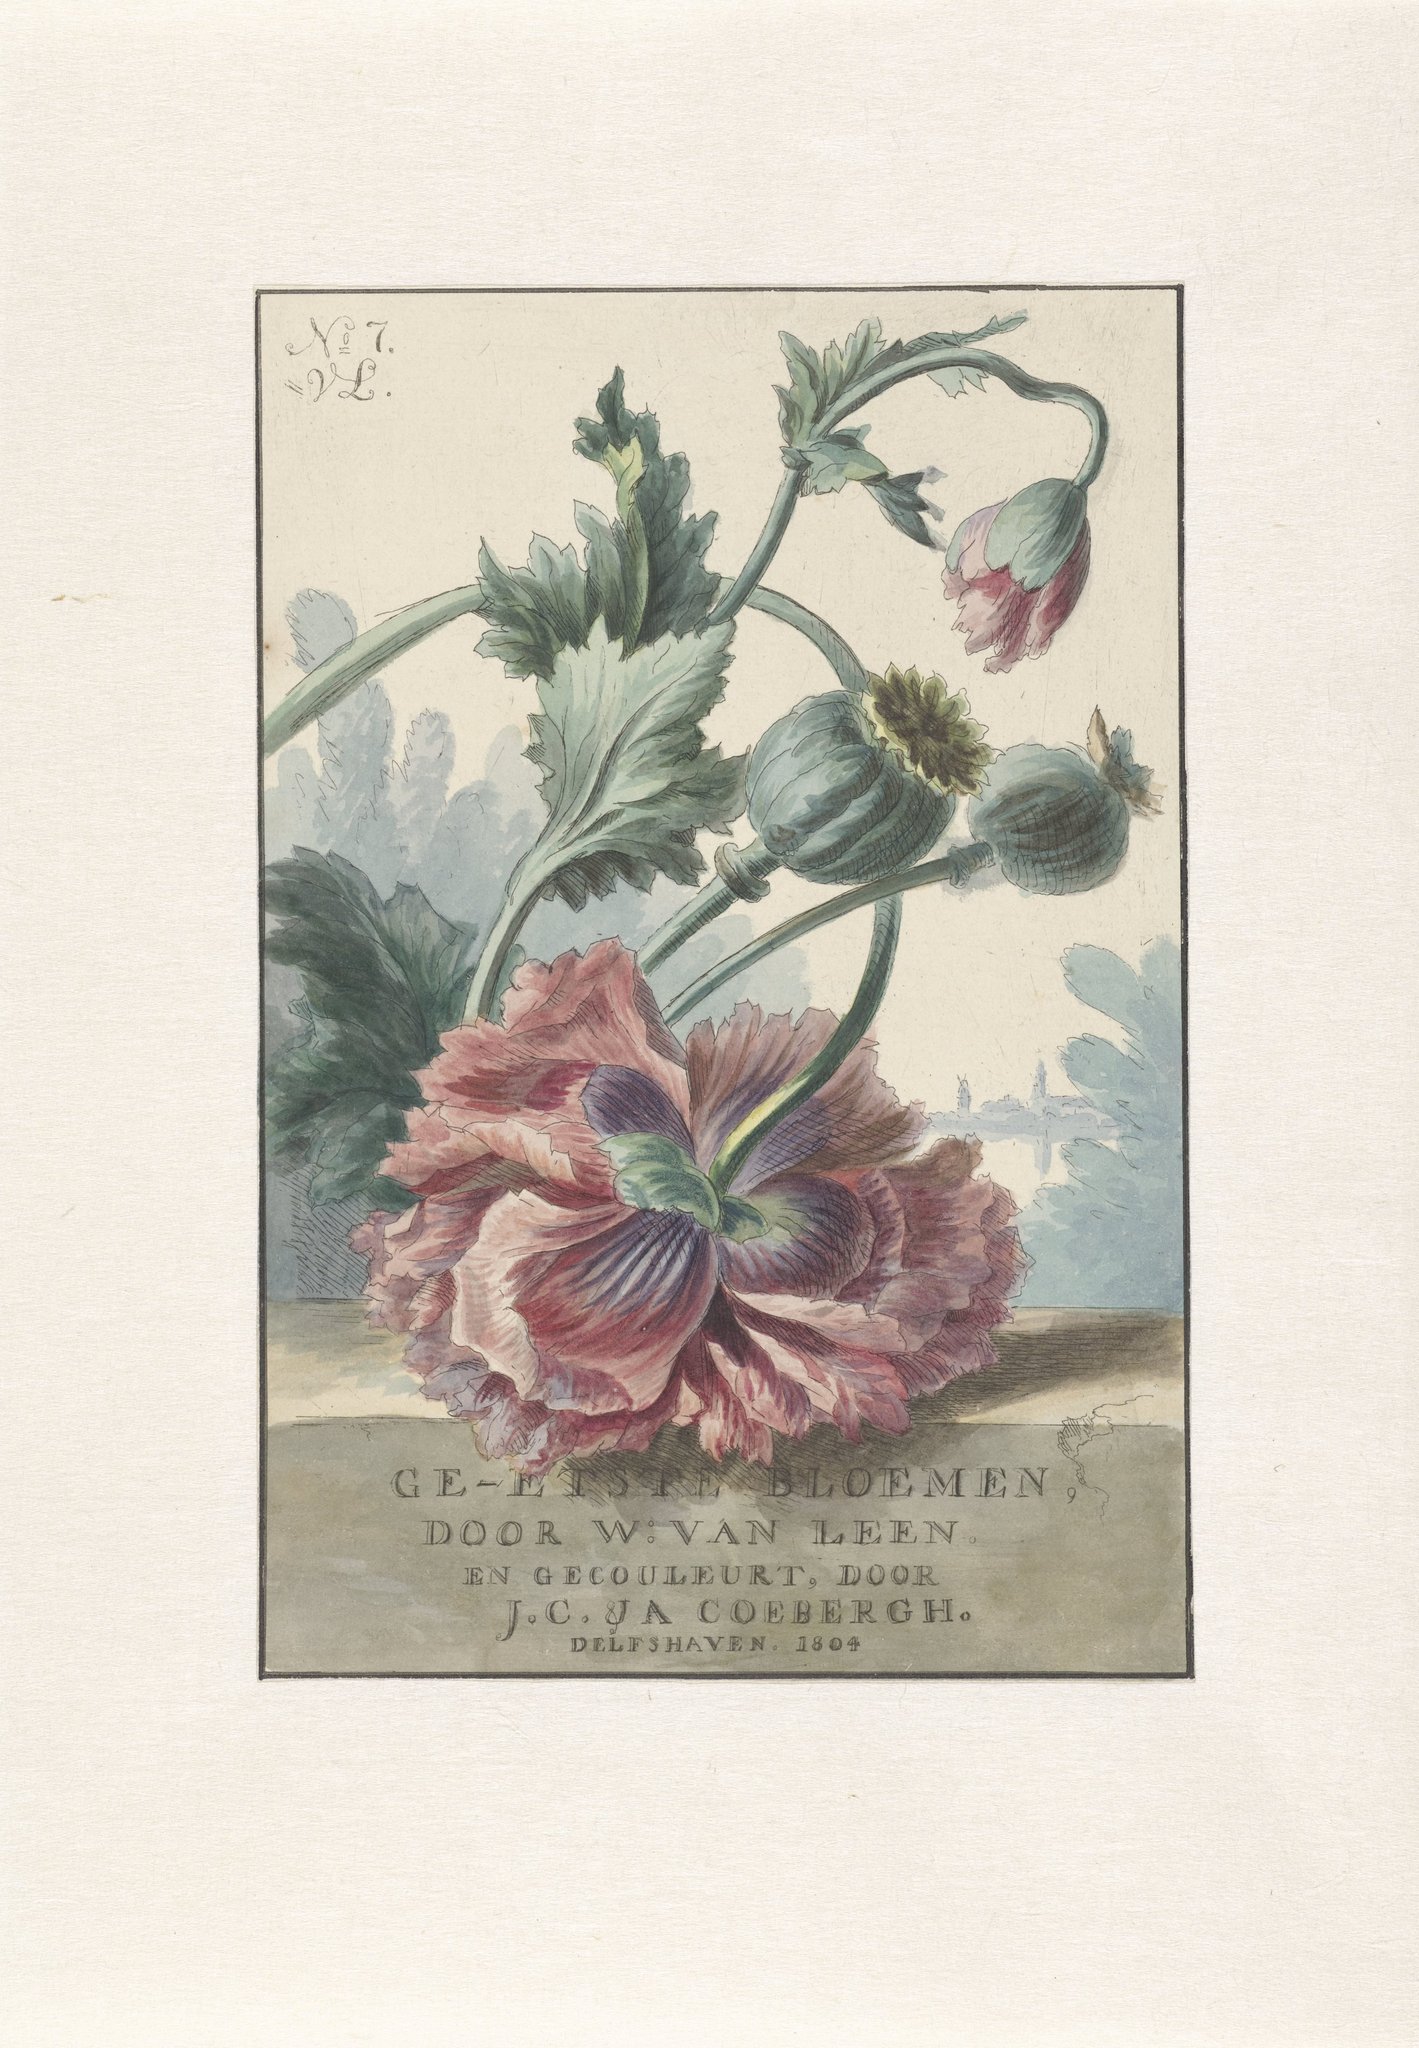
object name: titelprent, frontispice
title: Titelprent voor: W. van Leen en J.C. & J.A. Coebergh, Ge-etste Bloemen, 1804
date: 1804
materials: paper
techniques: etching, hand coloring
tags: flowers: poppy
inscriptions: collector's mark: Lugt 2760, collector's mark: Lugt 2228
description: Bloemenstudie van klaprozen. De prent maakt deel uit van een serie prenten met voorstellingen van diverse bloemen. Prent linksboven gemerkt: No 7.